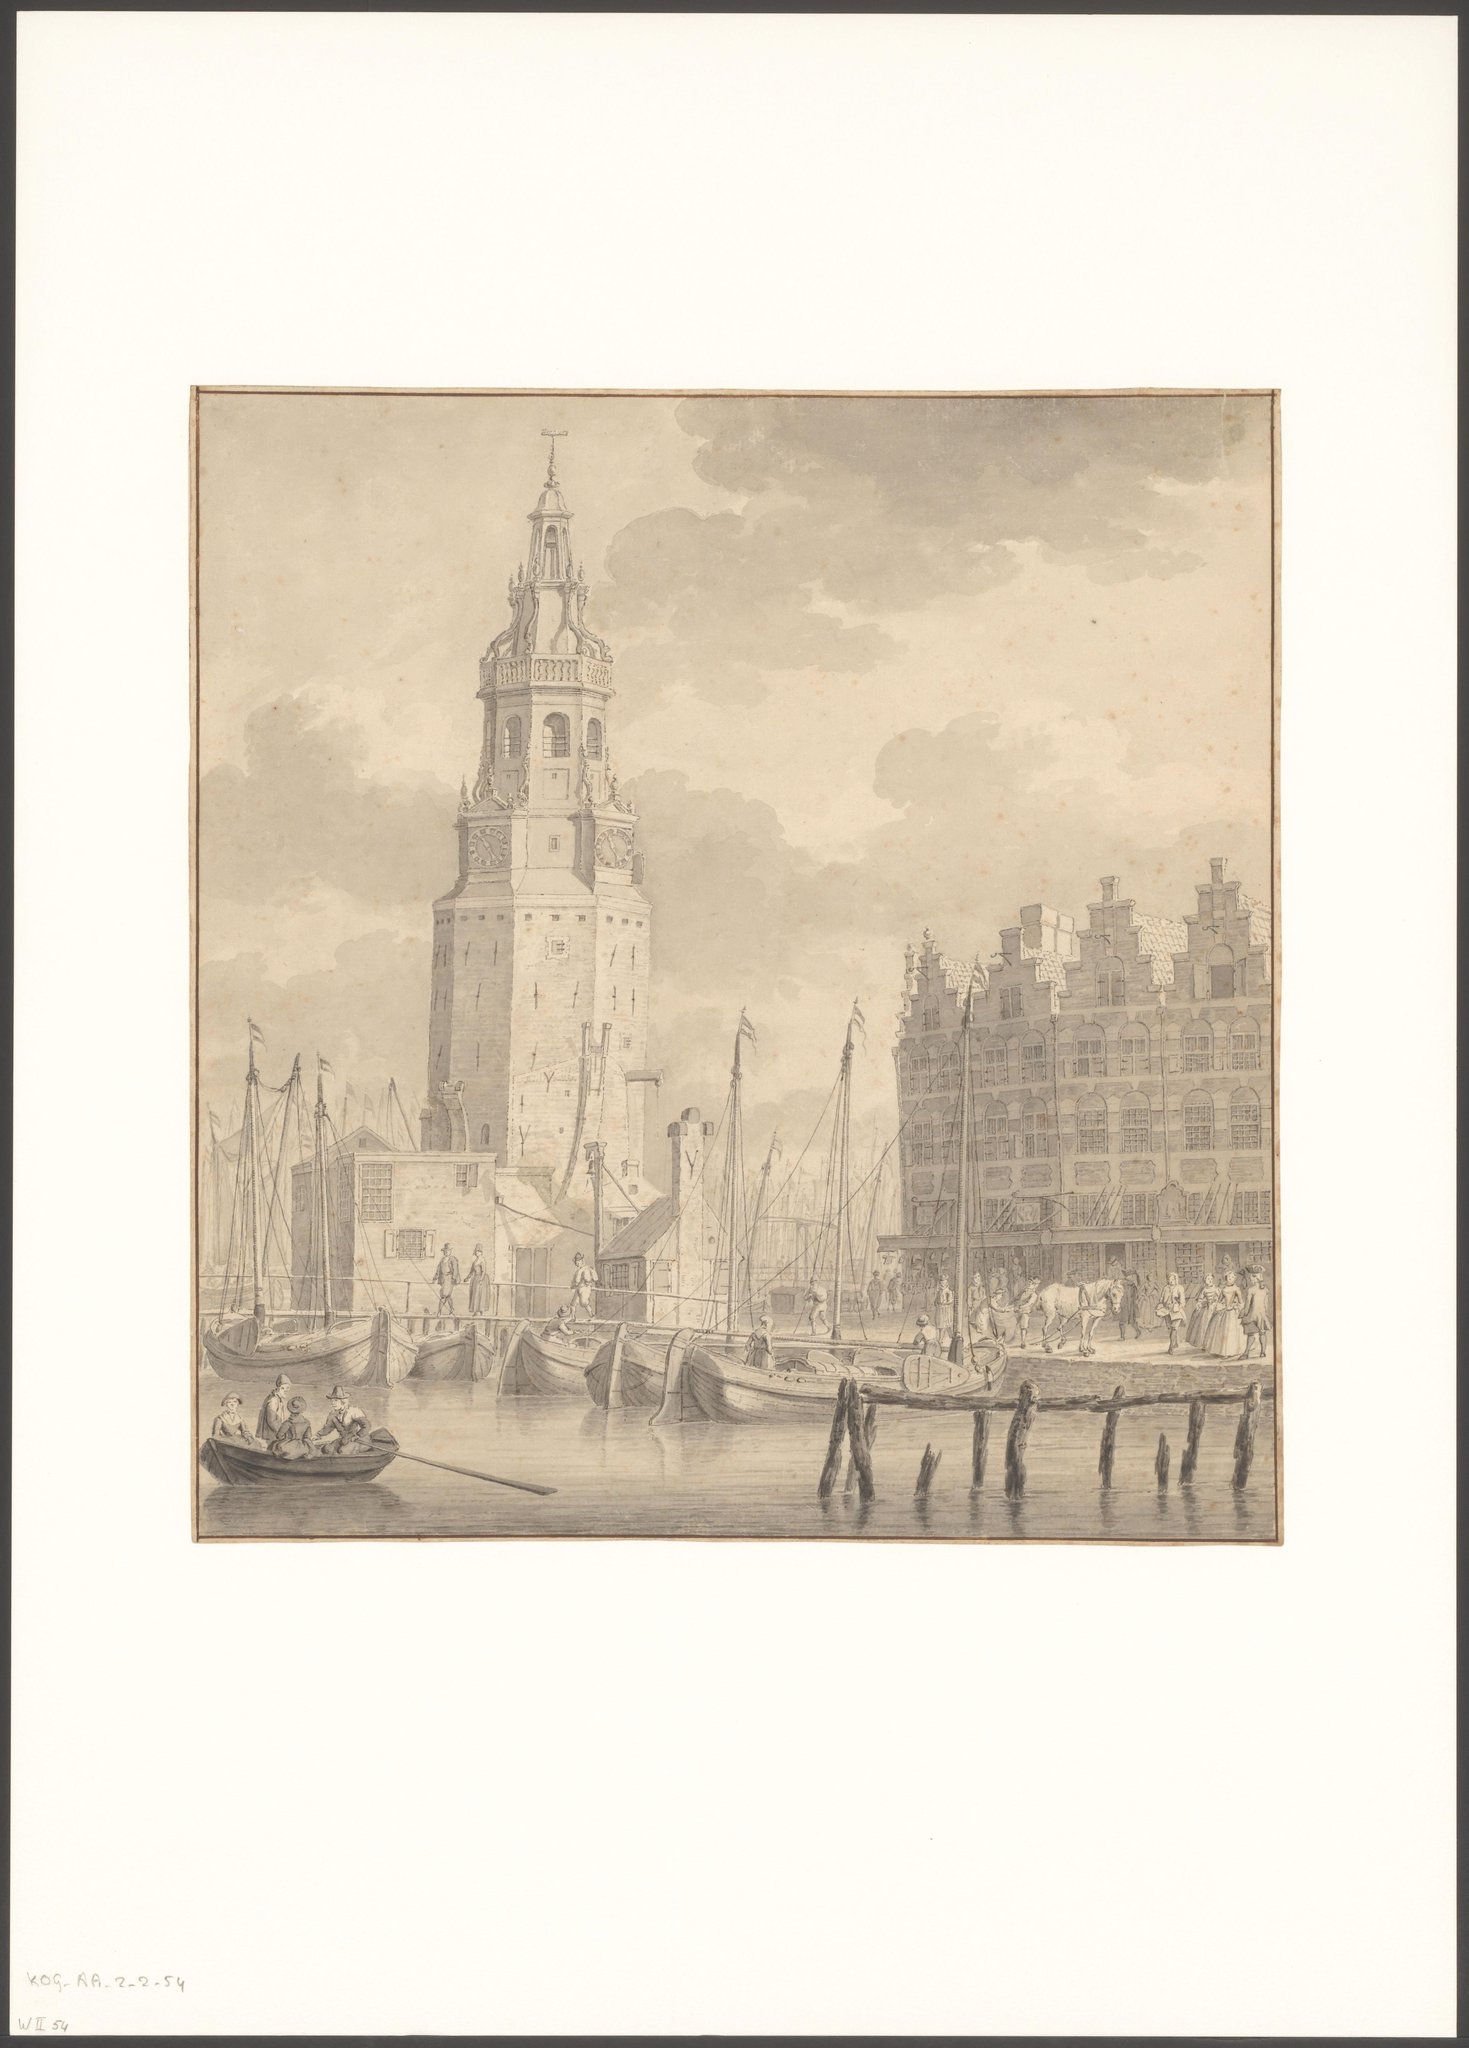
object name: drawing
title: Gezicht op de Haringpakkerij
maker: Anonymous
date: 1750-1829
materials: ink, paper, pencil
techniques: brush, pen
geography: amsterdam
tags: sailing-ship, sailing-boat, tower, clock tower ~ monumental adornment, city-view in general; 'veduta', canal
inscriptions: collector's mark: Lugt 800a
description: Tekening binnen de Atlas Van Eck ingedeeld op wijknummer 2.